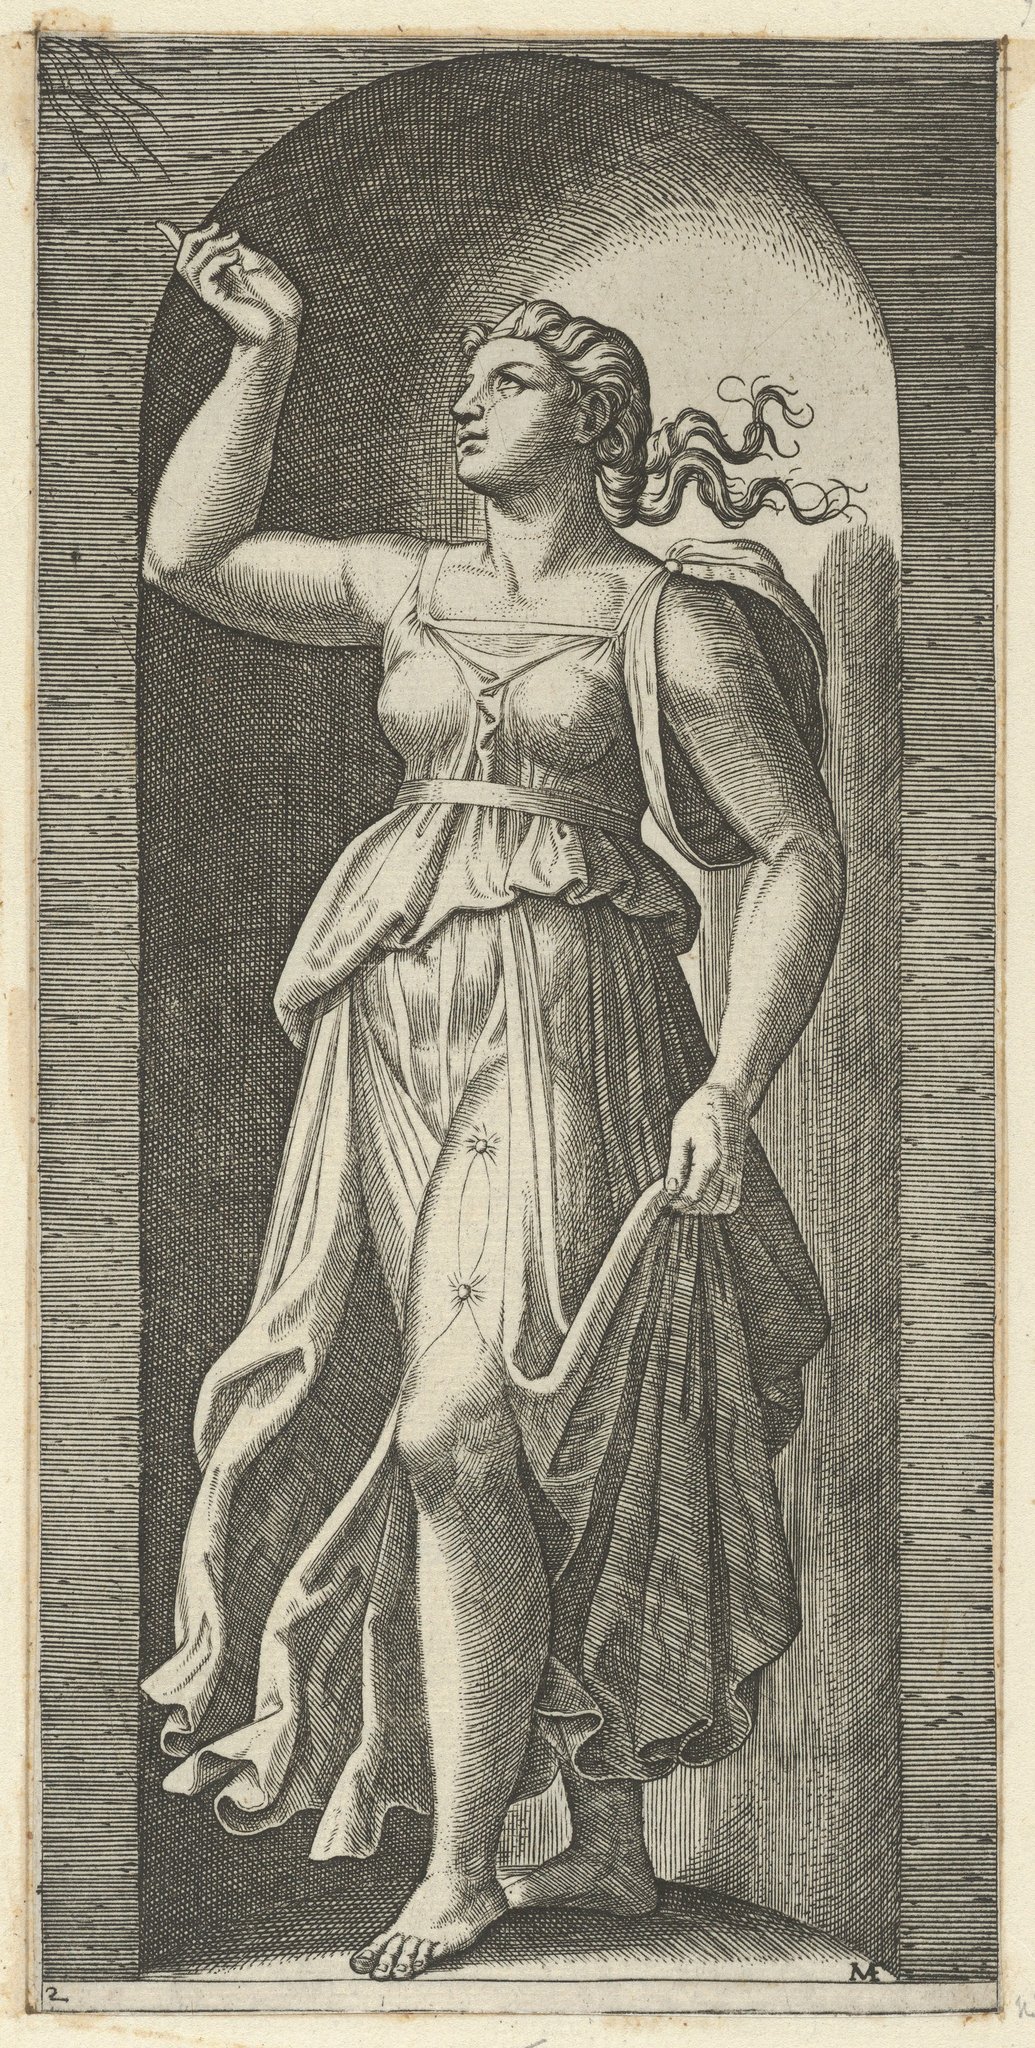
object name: print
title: Faith personified by a woman standing in a niche, pointing to rays in the upper left, from "The Virtues"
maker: marcantonio raimondi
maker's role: artist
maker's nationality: italian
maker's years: 1475-1534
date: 1515-1525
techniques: engraving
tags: women